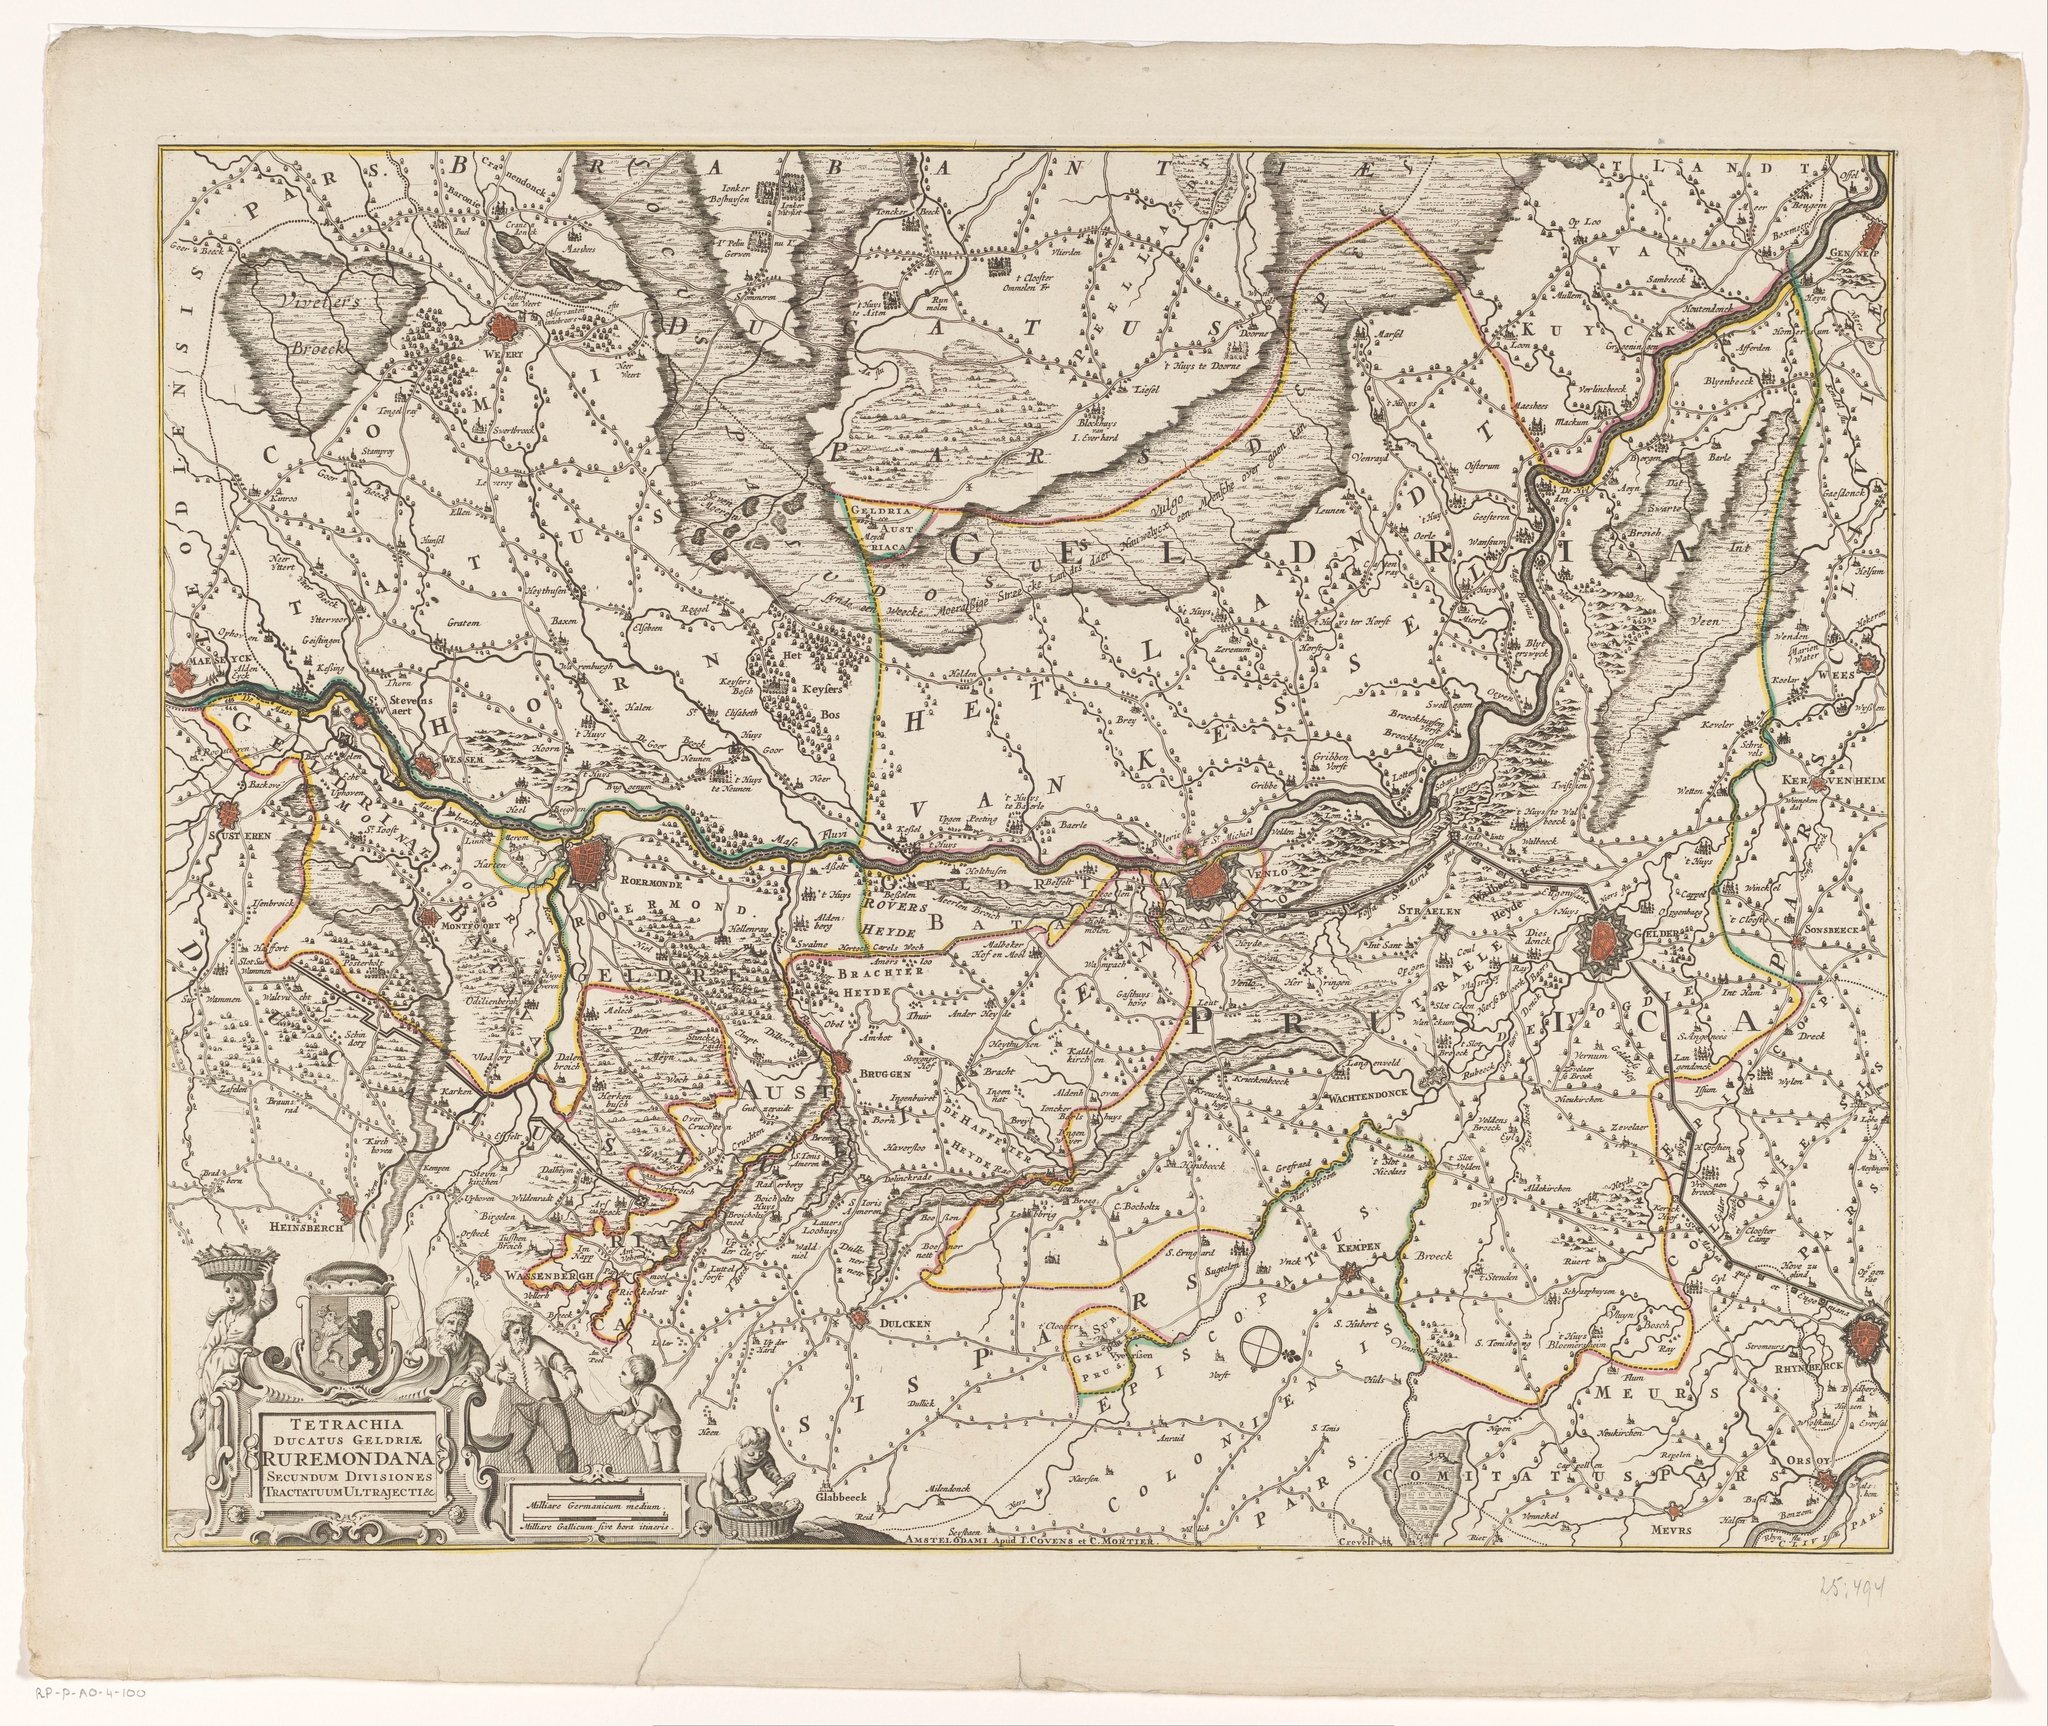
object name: print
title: Kaart van het Overkwartier van Gelre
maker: Anonymous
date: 1648-1706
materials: paper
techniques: engraving, etching, hand coloring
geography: amsterdam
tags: coat of arms (as symbol of the state, etc.), maps of separate countries or regions, fisherman, cleves, upper guelders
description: Linksonder een cartouche met de titel en het wapen van het hertogdom Gelre. Daarnaast twee schaalstokken: Milliare Germanicum medium, Milliare Gallicum sive hora itineris. Daaromheen een aantal vissers.